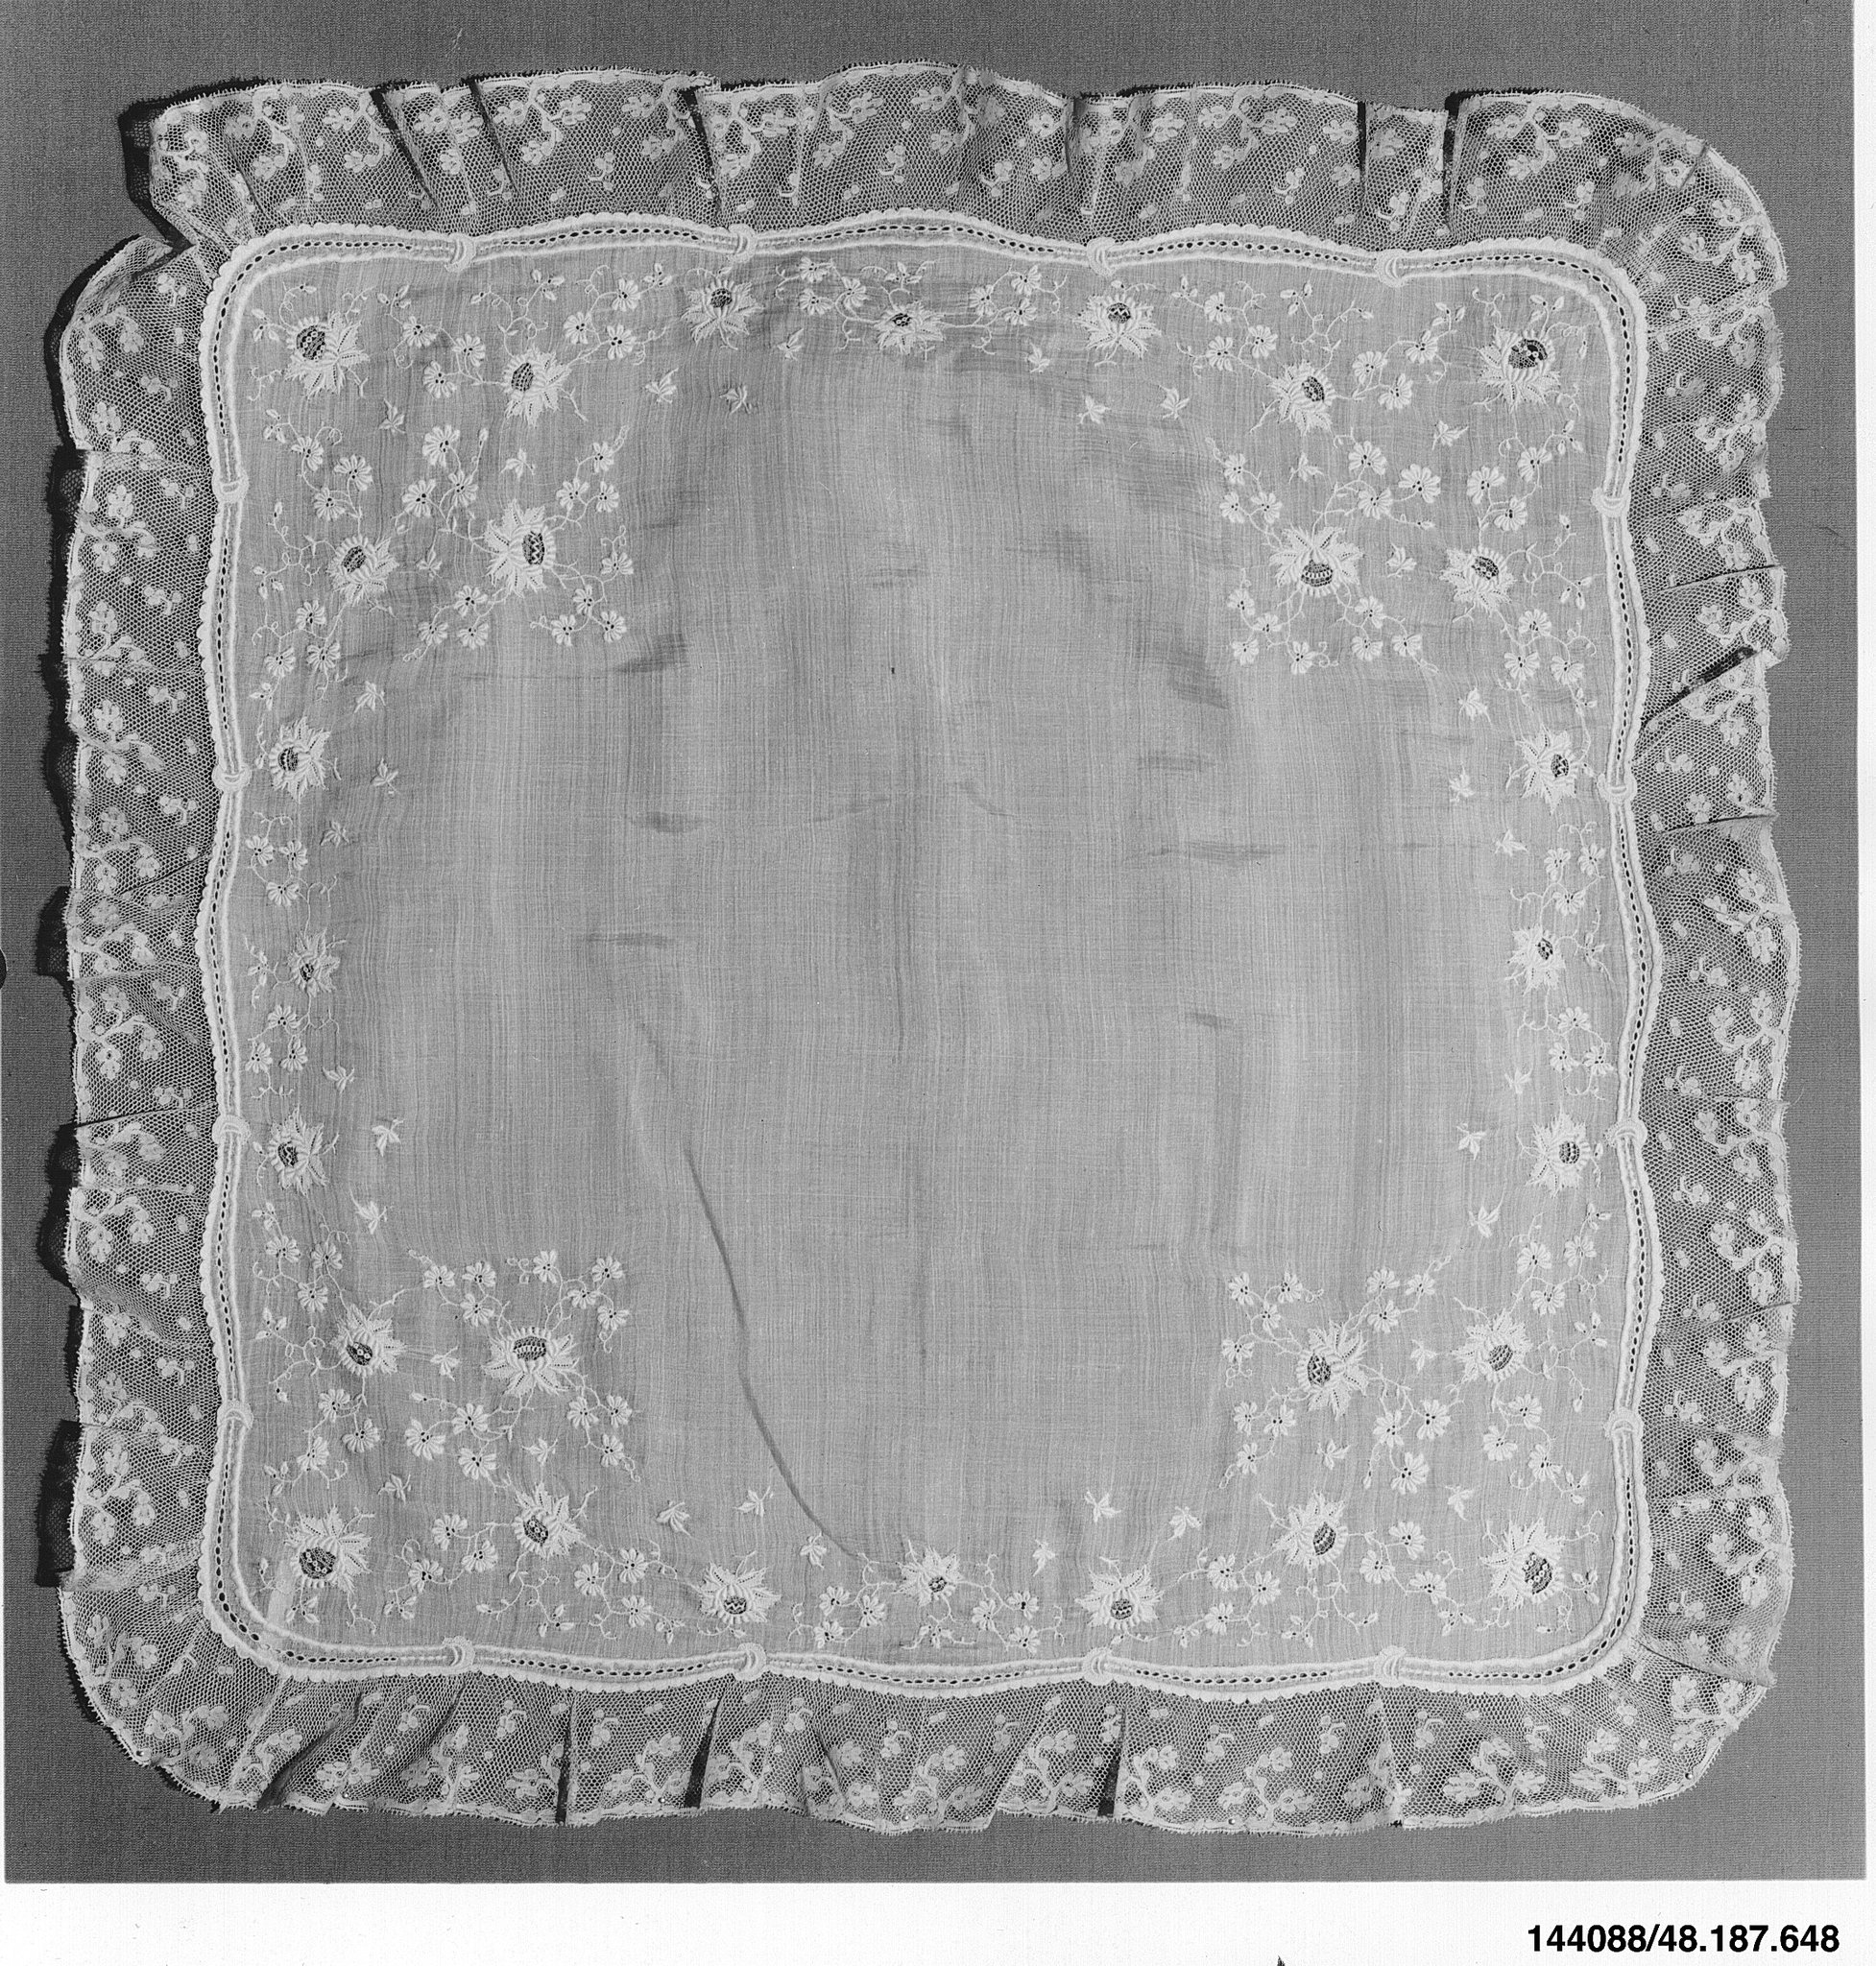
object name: handkerchief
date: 1834-1866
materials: lace, linen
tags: flowers